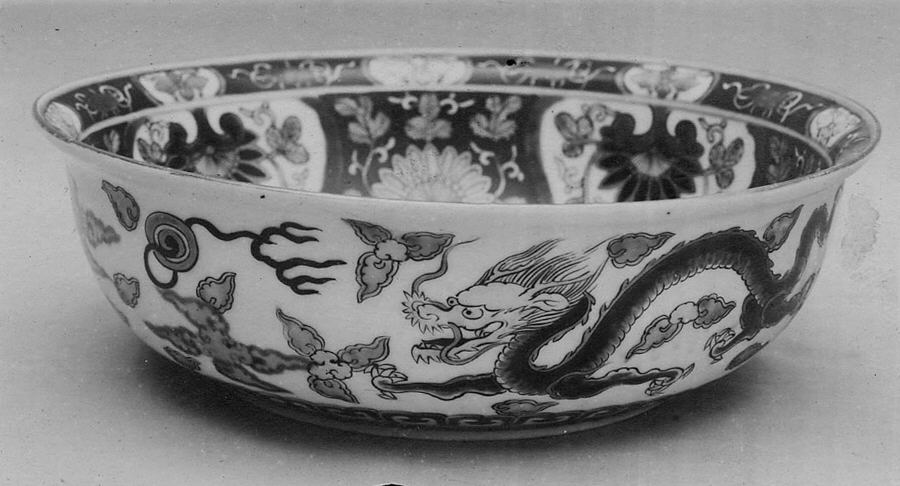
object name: bowl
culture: japanese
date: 1750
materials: enamel, glaze, porcelain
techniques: polychrome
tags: dragons,flowers